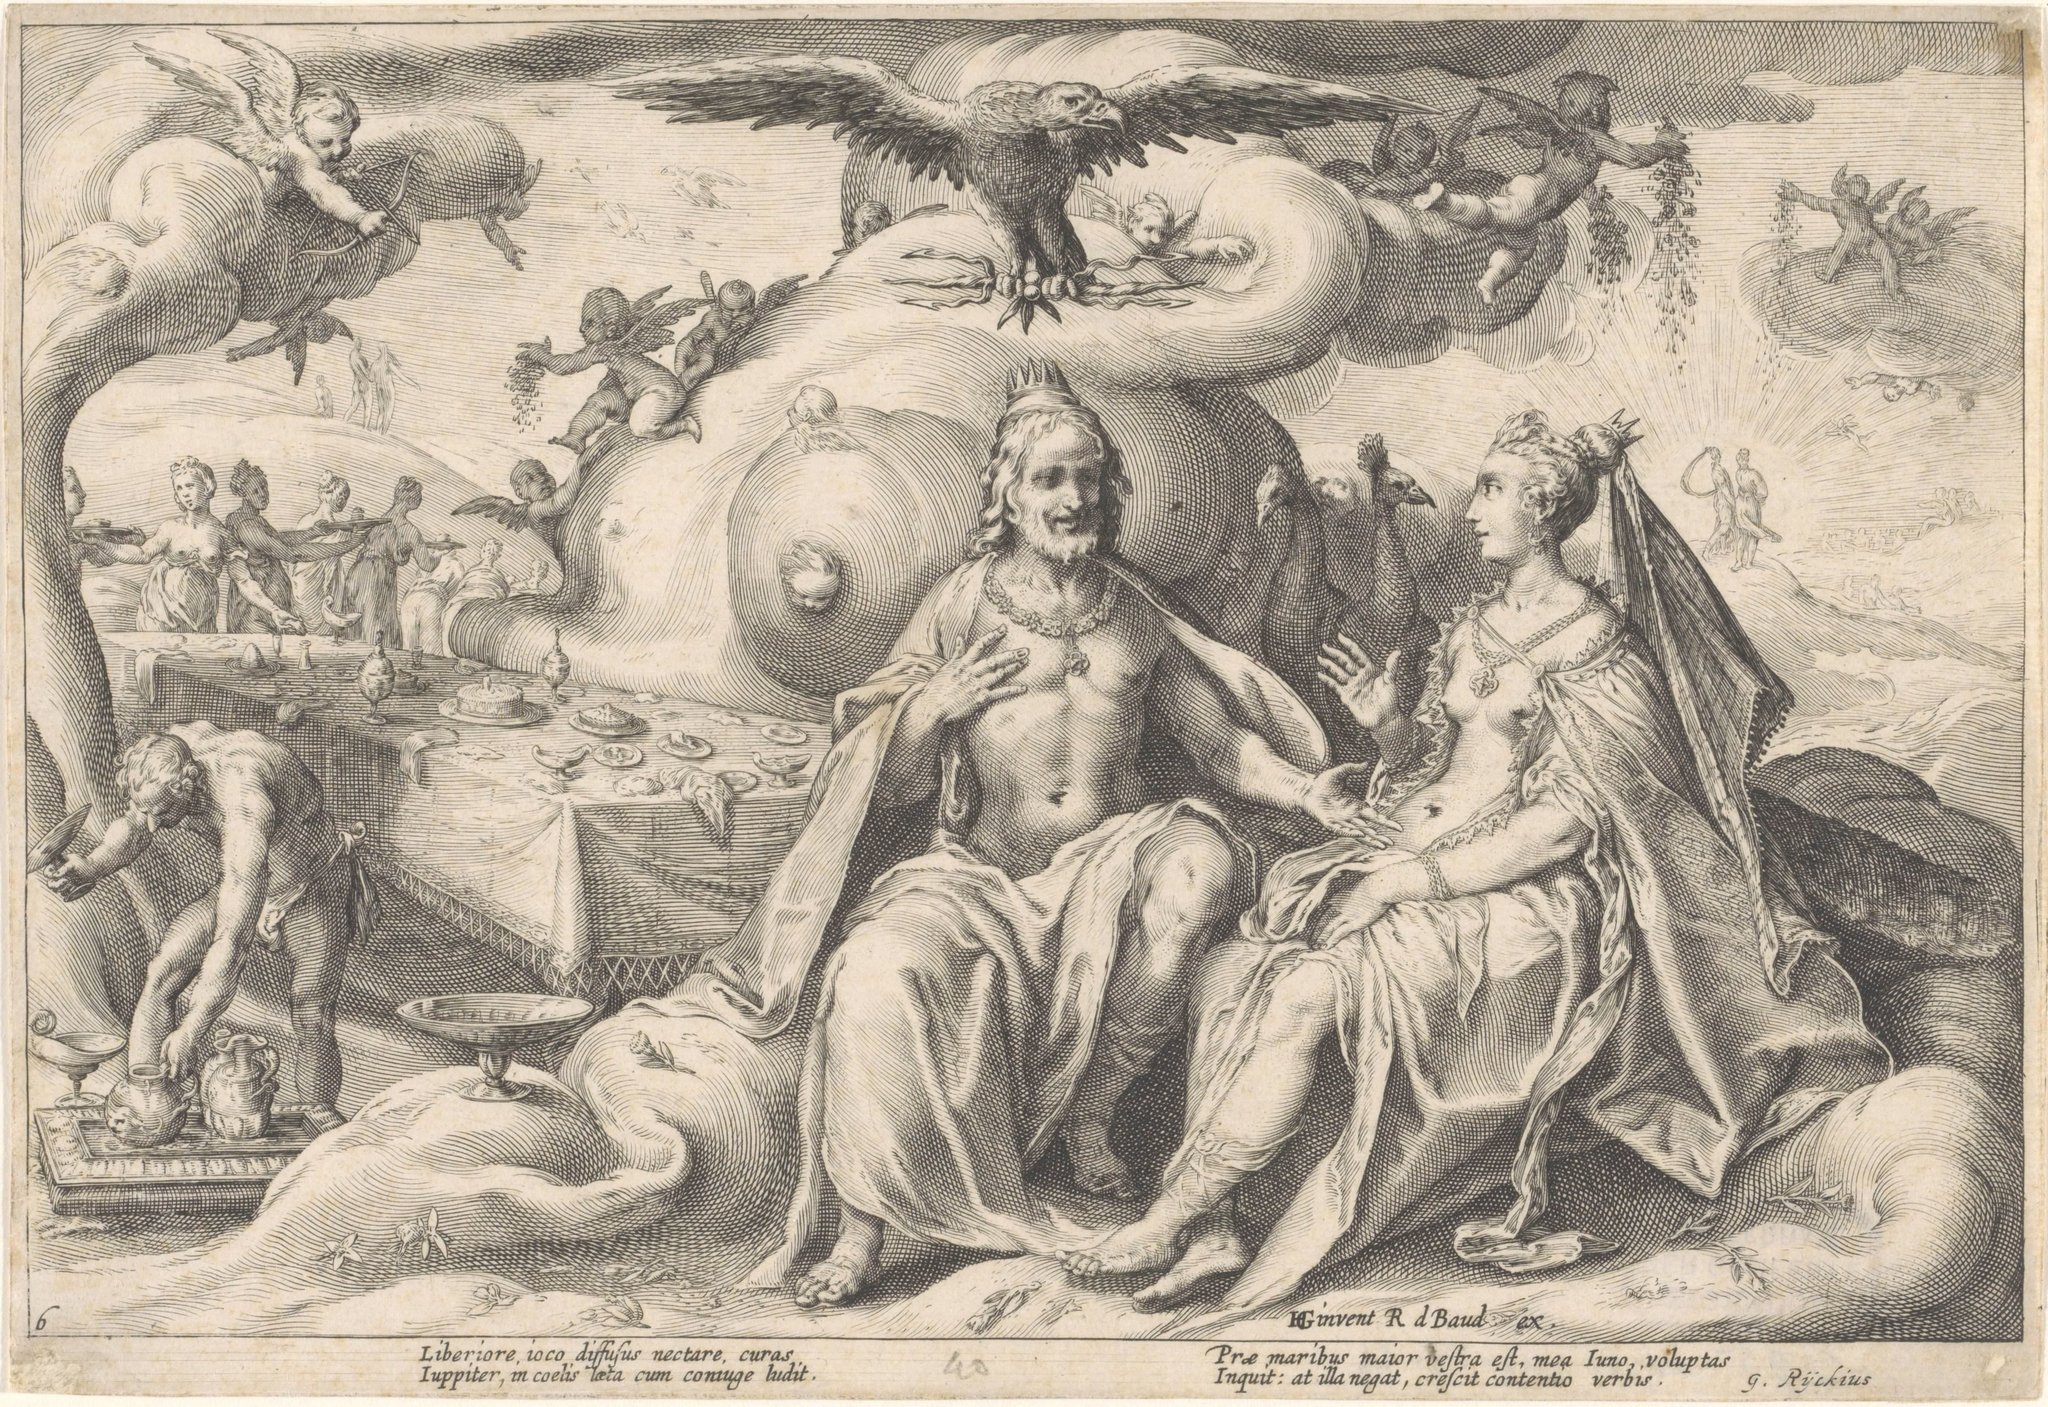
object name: print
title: Discussie tussen Jupiter en Juno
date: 1615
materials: paper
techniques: engraving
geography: haarlem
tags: (story of) juno (hera), (story of) jupiter (zeus)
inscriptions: collector's mark: ‘Hinloopen’, collector's mark: Lugt 11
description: Jupiter en Juno zitten naast elkaar, voor een lange tafel die wordt afgeruimd, en discussiëren over de vraag welke van de seksen het grootste genot kan ervaren in de liefde. Jupiter stelt dat dat het voorrecht van de vrouw is, Juno spreekt hem tegen. In de ondermarge een vierregelige toelichting, in twee kolommen, in het Latijn.